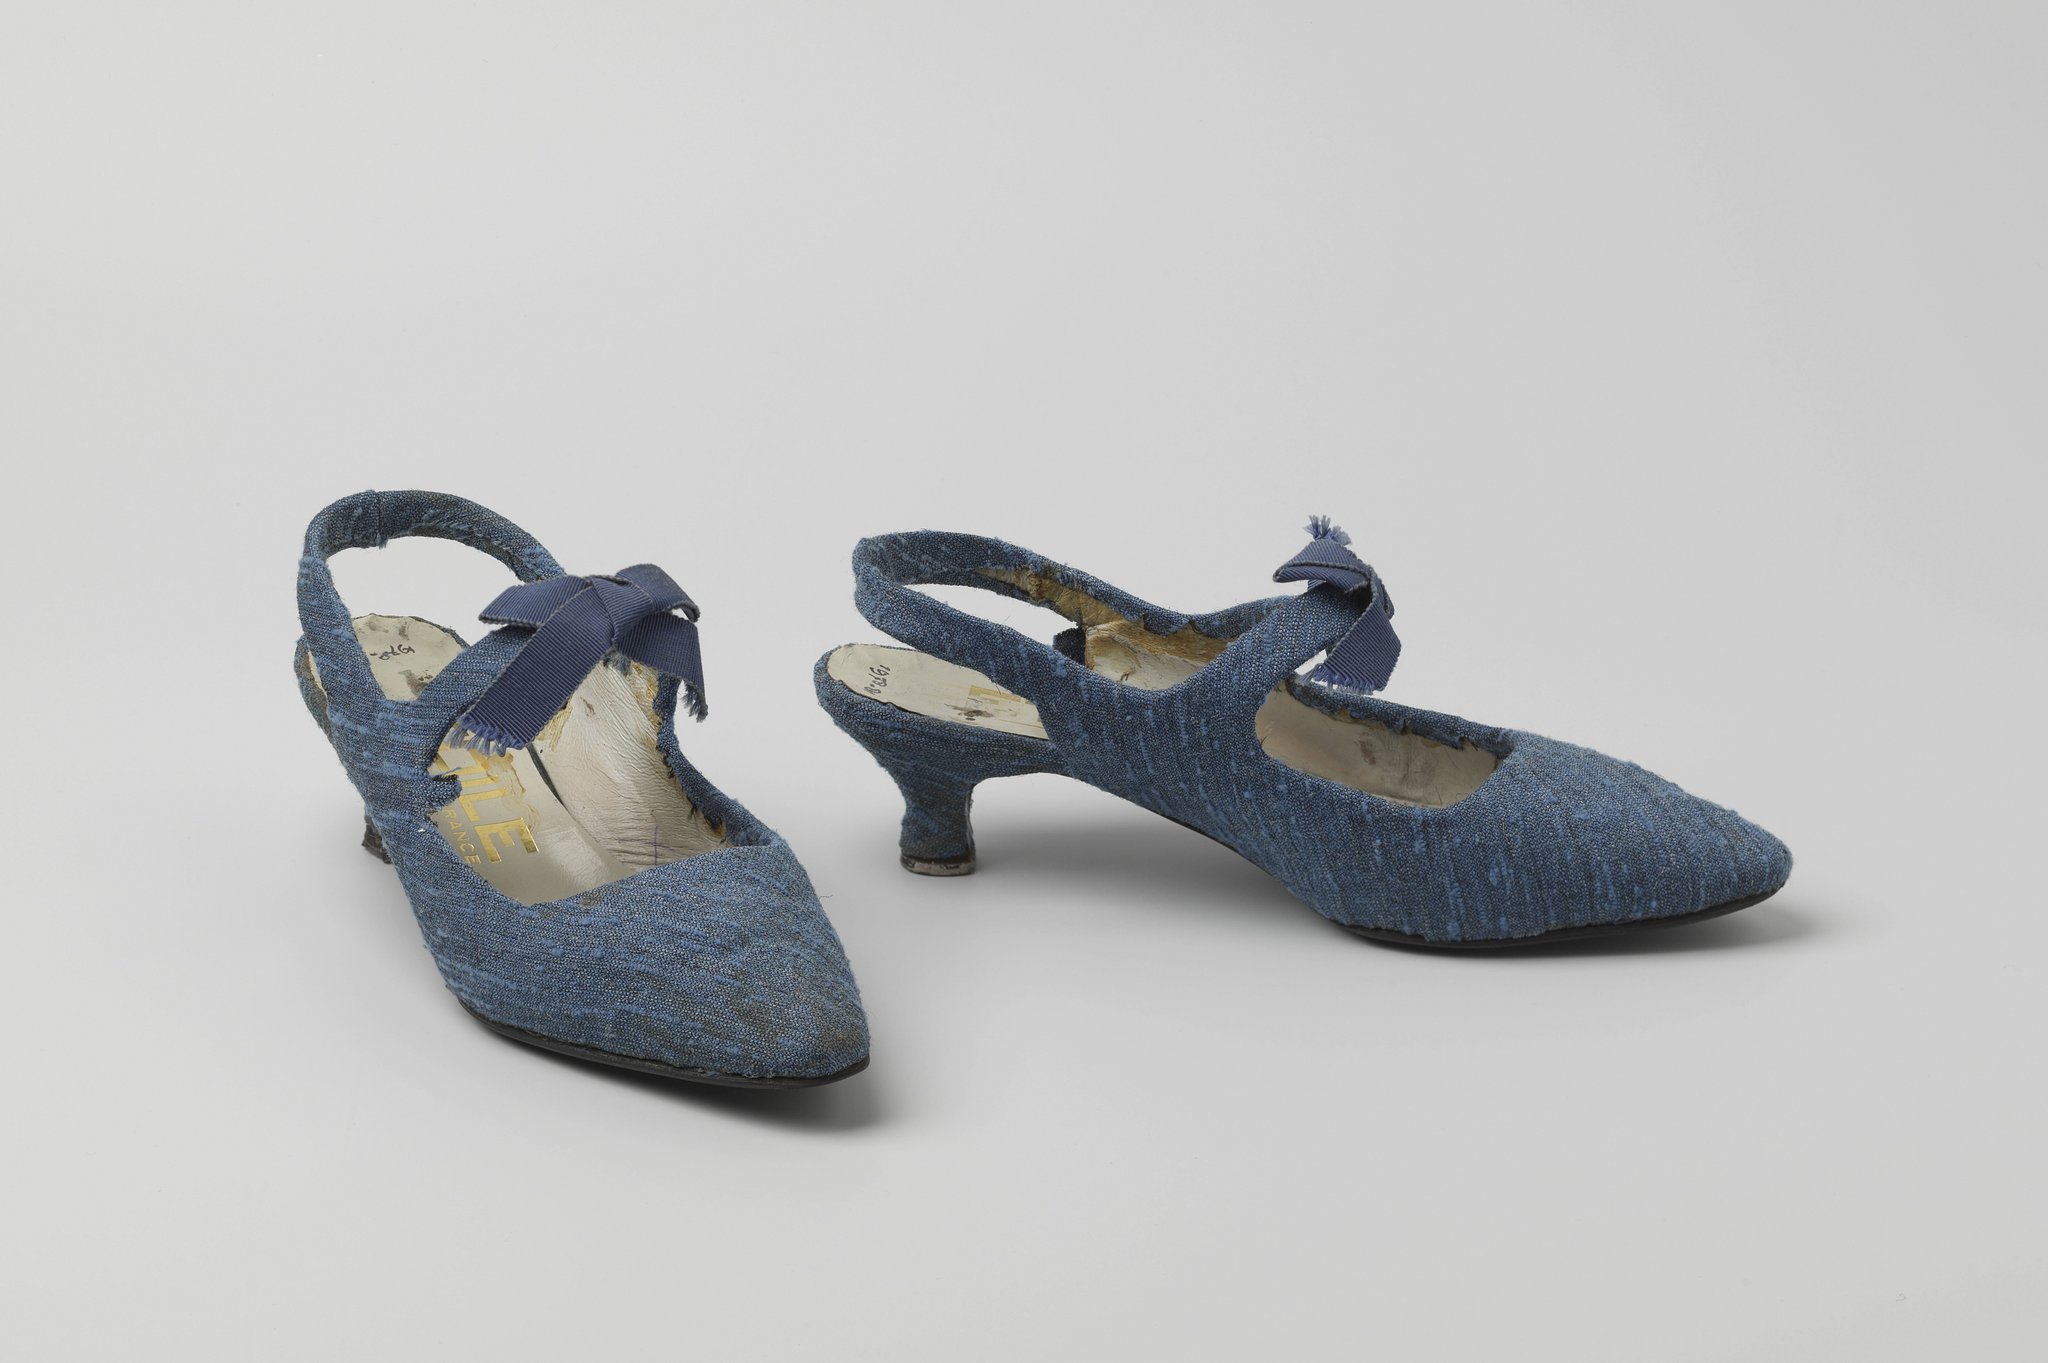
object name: mary jane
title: Dameschoen van blauwe wol met band achter de hiel en wreefband met strik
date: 1950-1962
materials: leather, metal, plastic, rubber, silk, wool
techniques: casting, tanning, weave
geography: paris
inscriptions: inscription: ‘4800 // 4’, company name: ‘ETOILE // MADE IN FRANCE’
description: Damesschoen van blauwe wol met band achter de hiel en wreefband. Model: Slingback: spitse, afgeronde neus, blad uit één stuk stof. Halverwege de schoen een wreefband. Open hiel en band die achter de hiel langsloopt. De voorkant van de hak loopt in een afgeronde hoek recht naar beneden. De zijkant en achterkant van de hak loopt in een trechtervorm naar een smal uiteinde. De hak is bekleed met blauwe wol. Zwart kunststof achterlapje met drie spijkers aan de hak vastgeslagen en zwart rubberen zool. Blad gevoerd met ivoorwit leer. De binnenzool is van ivoorwit leer. Versiering: Midden op de wreefband een strik van blauwe ripszijde.